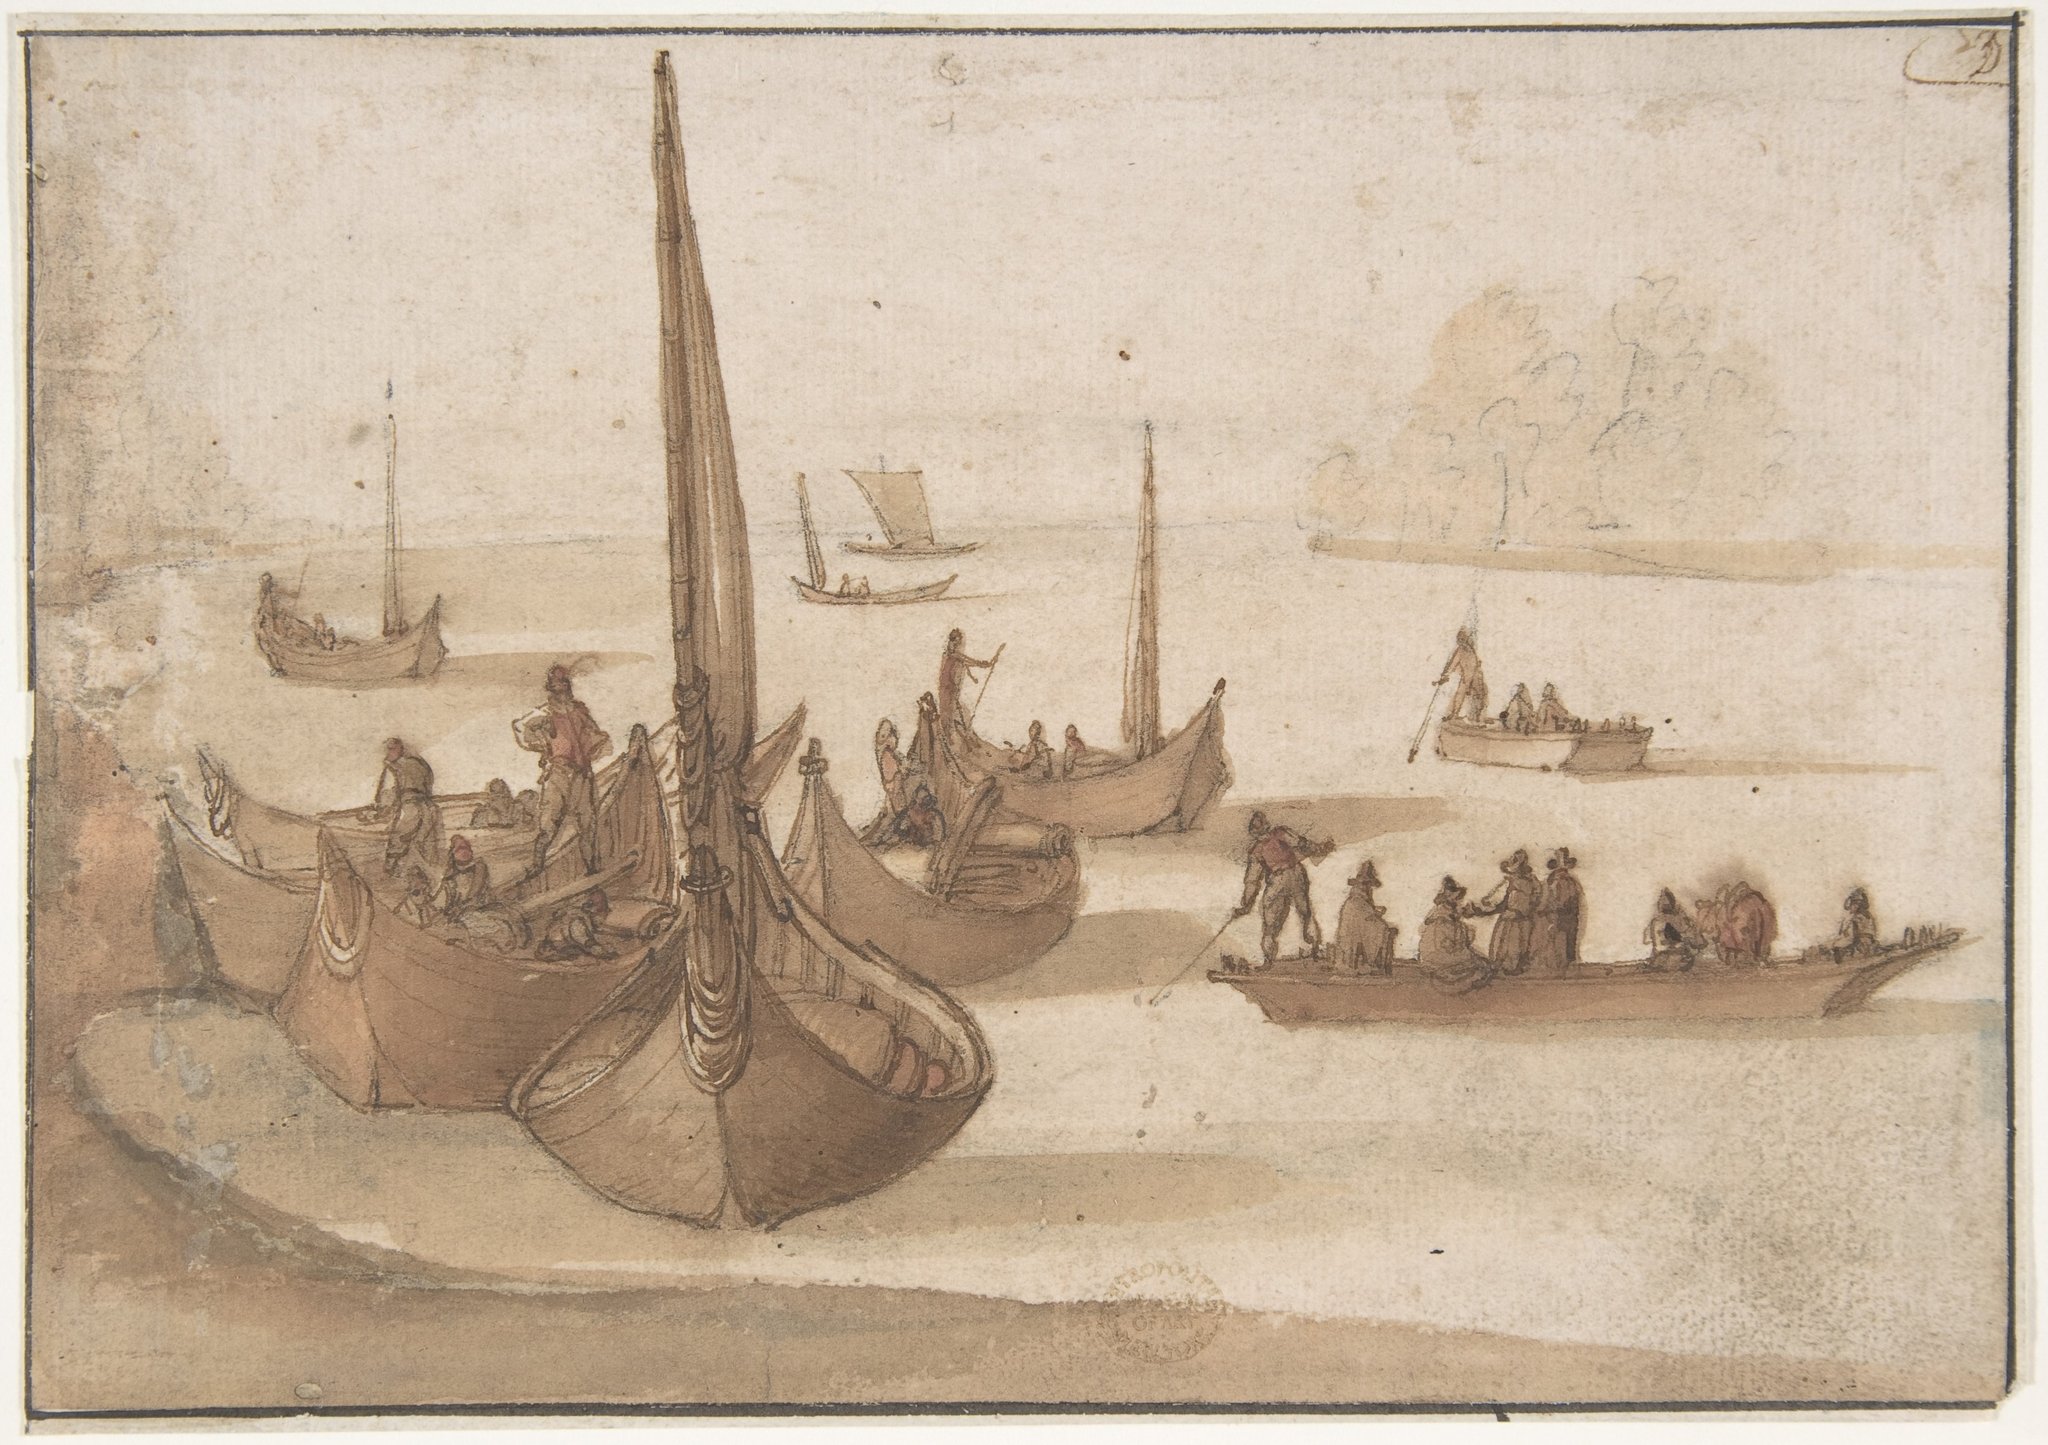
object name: drawing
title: River Scene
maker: jan brueghel the elder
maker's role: artist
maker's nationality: netherlandish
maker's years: 1568-1625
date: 1501-1600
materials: chalk, ink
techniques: pen, wash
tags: human figures,rivers,boats